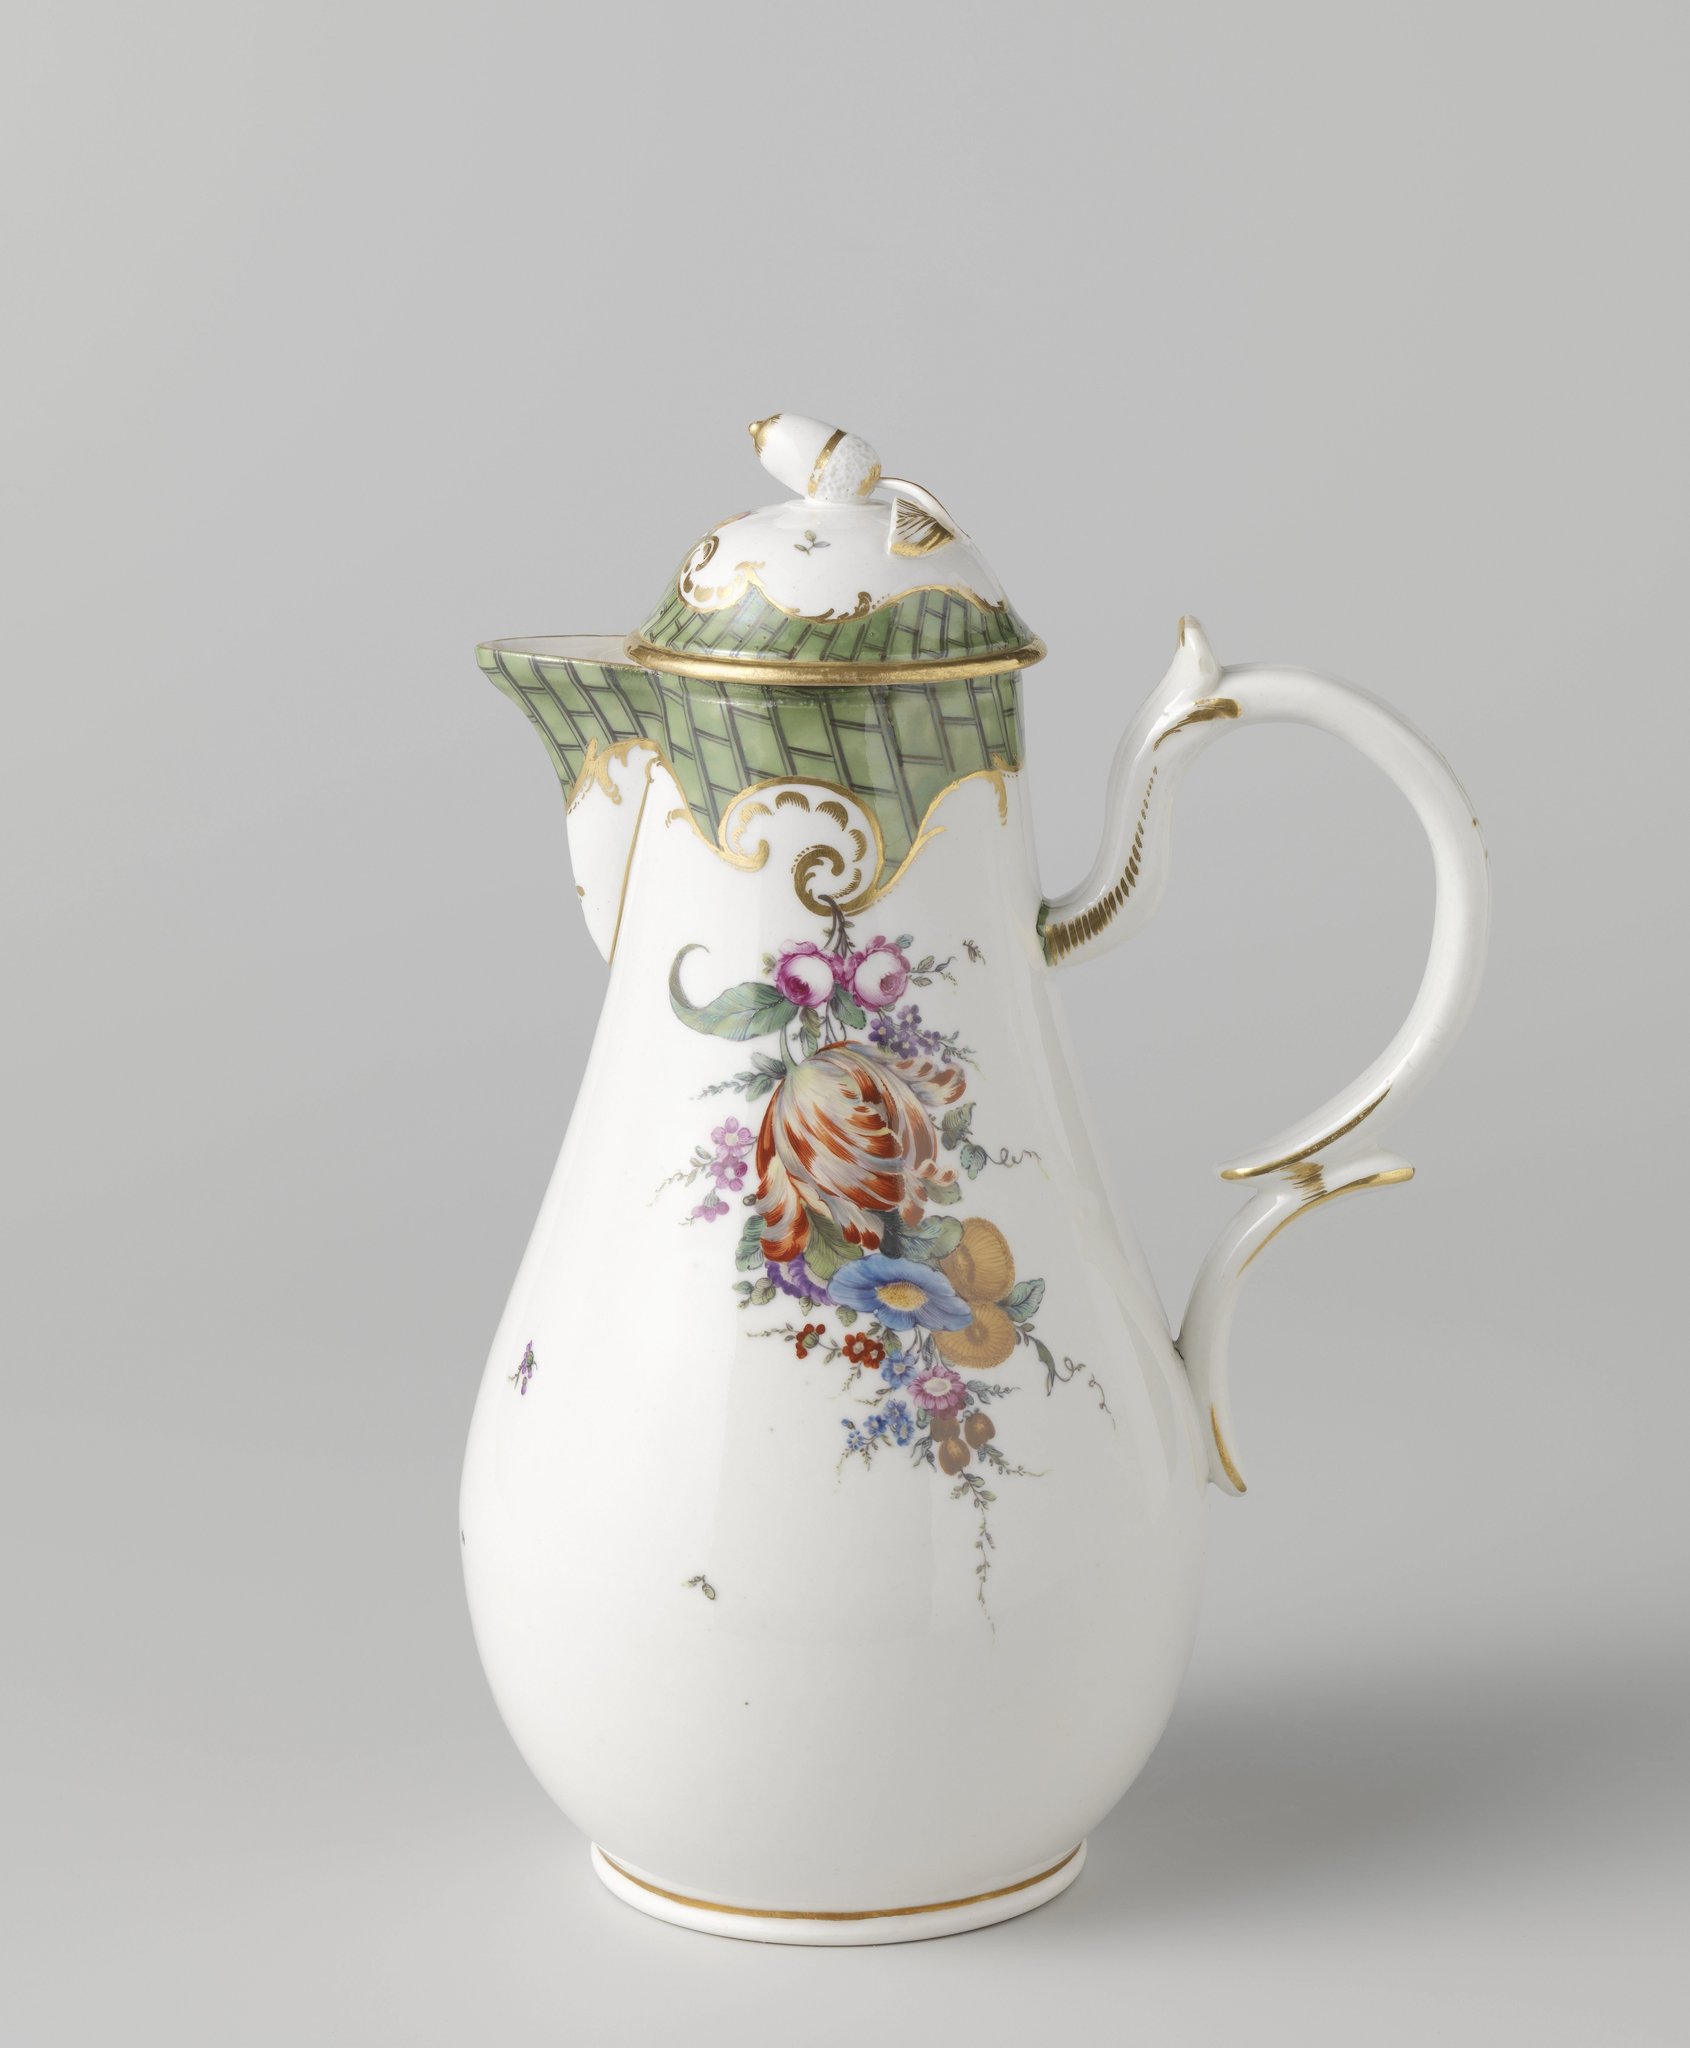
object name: coffee pot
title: Koffiekan met deksel, beschilderd met bloemen en laddermotief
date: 1775-1778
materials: porcelain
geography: loosdrecht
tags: flowers ~ ornament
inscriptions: mark: ‘L1’, factory mark: ‘M:OL’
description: Koffiekan van porselein. Beschilderd met bloemen en een laddermotief in heldere kleuren.